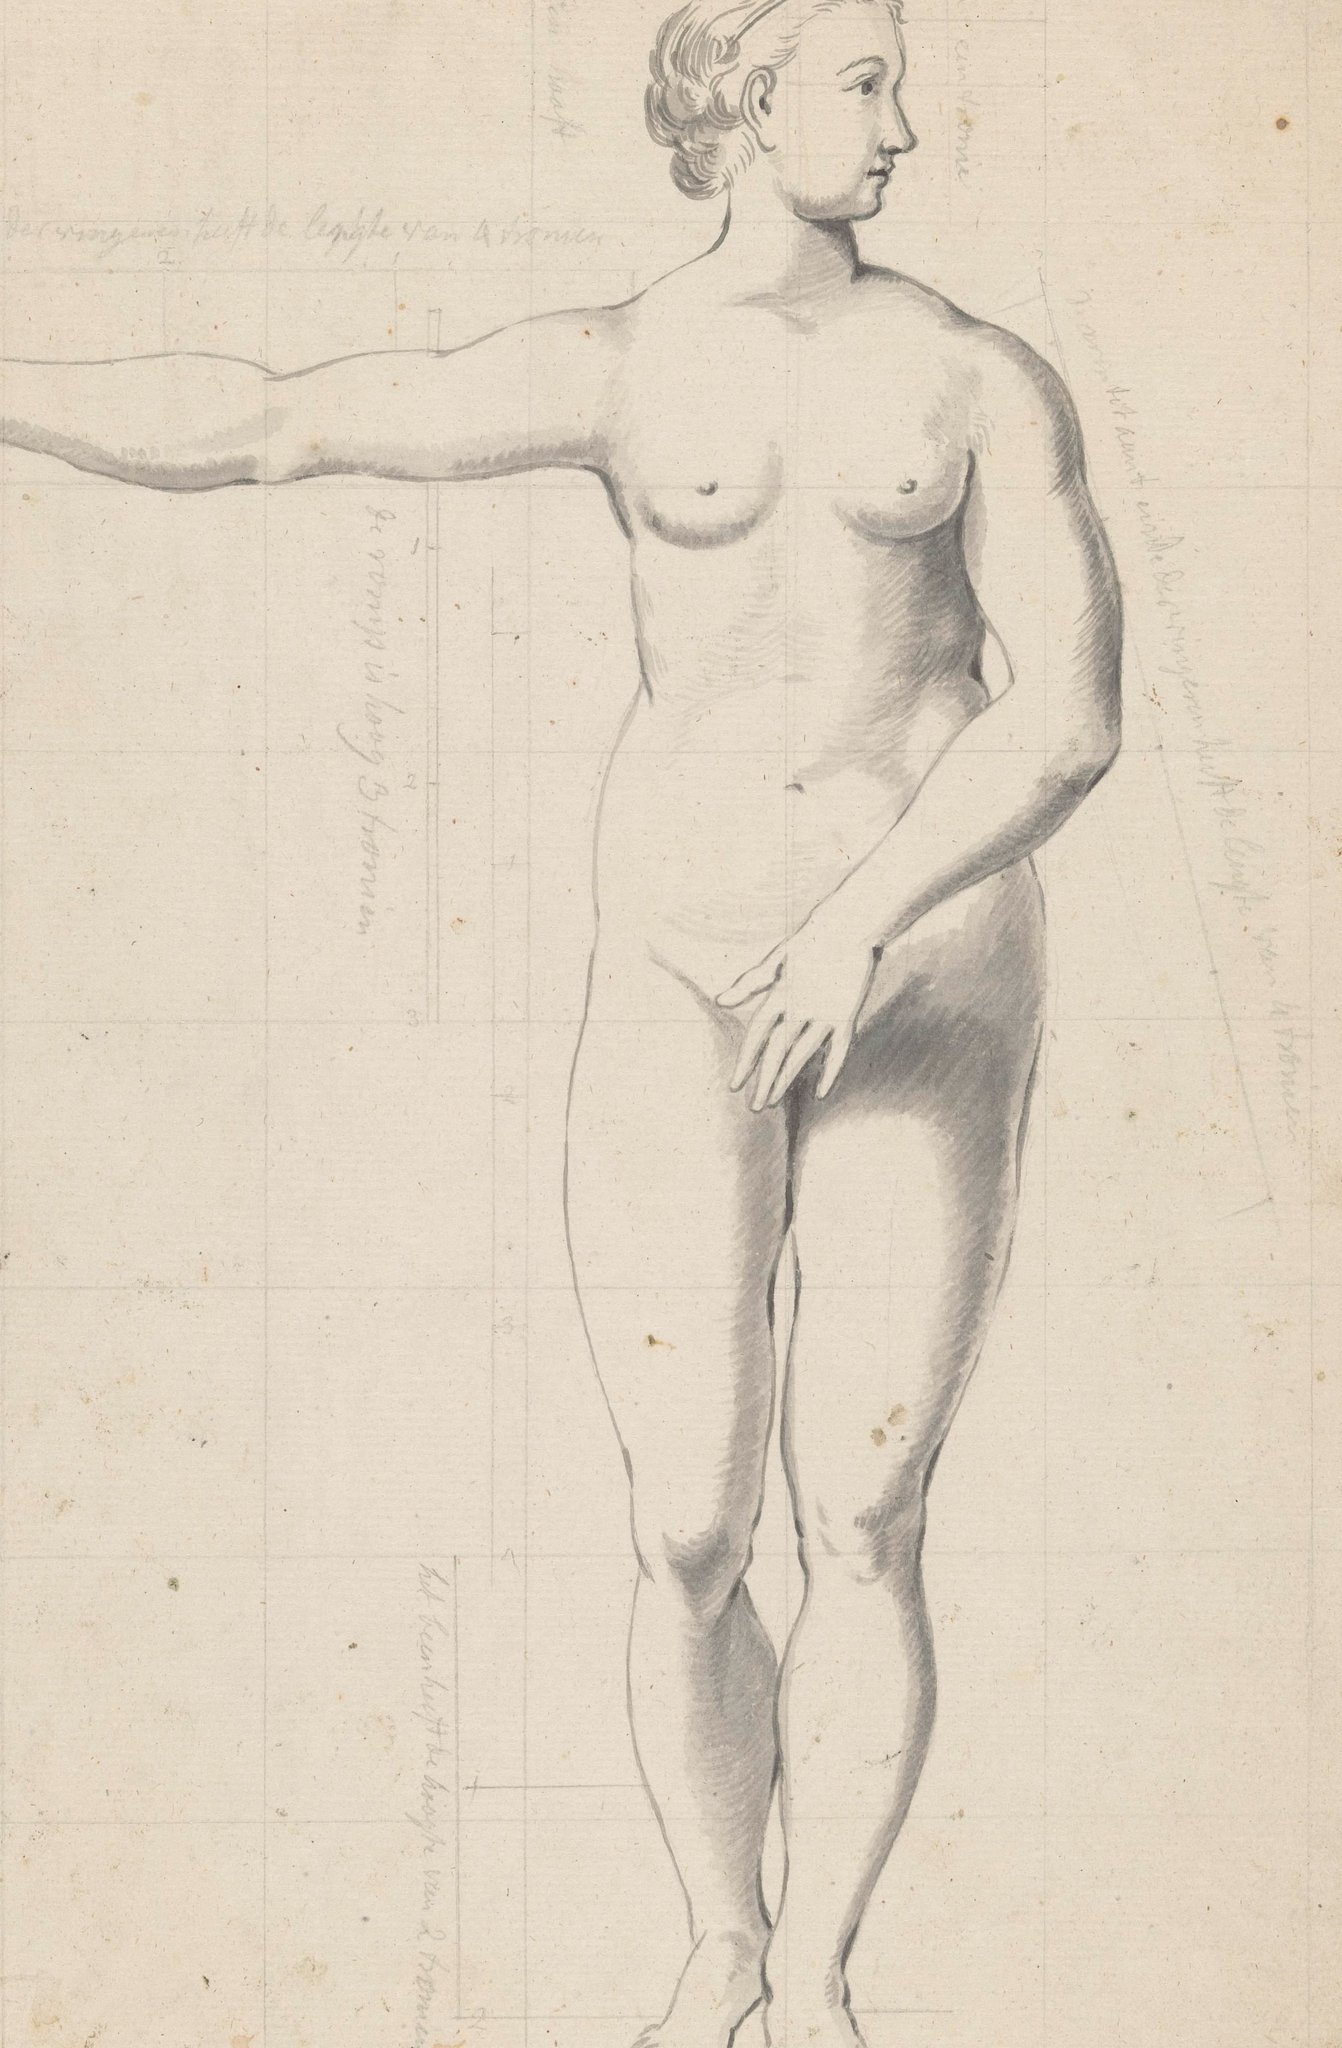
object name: drawing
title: Naaktstudies van vrouw en man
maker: jan brandes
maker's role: draughtsman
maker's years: 1743-1808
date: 1787-1808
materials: paper, pencil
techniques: brush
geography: skälsebo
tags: standing figure (canon, proportions) - aa - female human figure, standing figure - aa - female human figure, standing figure (canon, proportions)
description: Dubbelgevouwen blad met schematische figuurstudies van staande naakte vrouw en man. Met allerlei verhoudingen en afmetingen. Gekopieerd uit een voorbeeldboek.